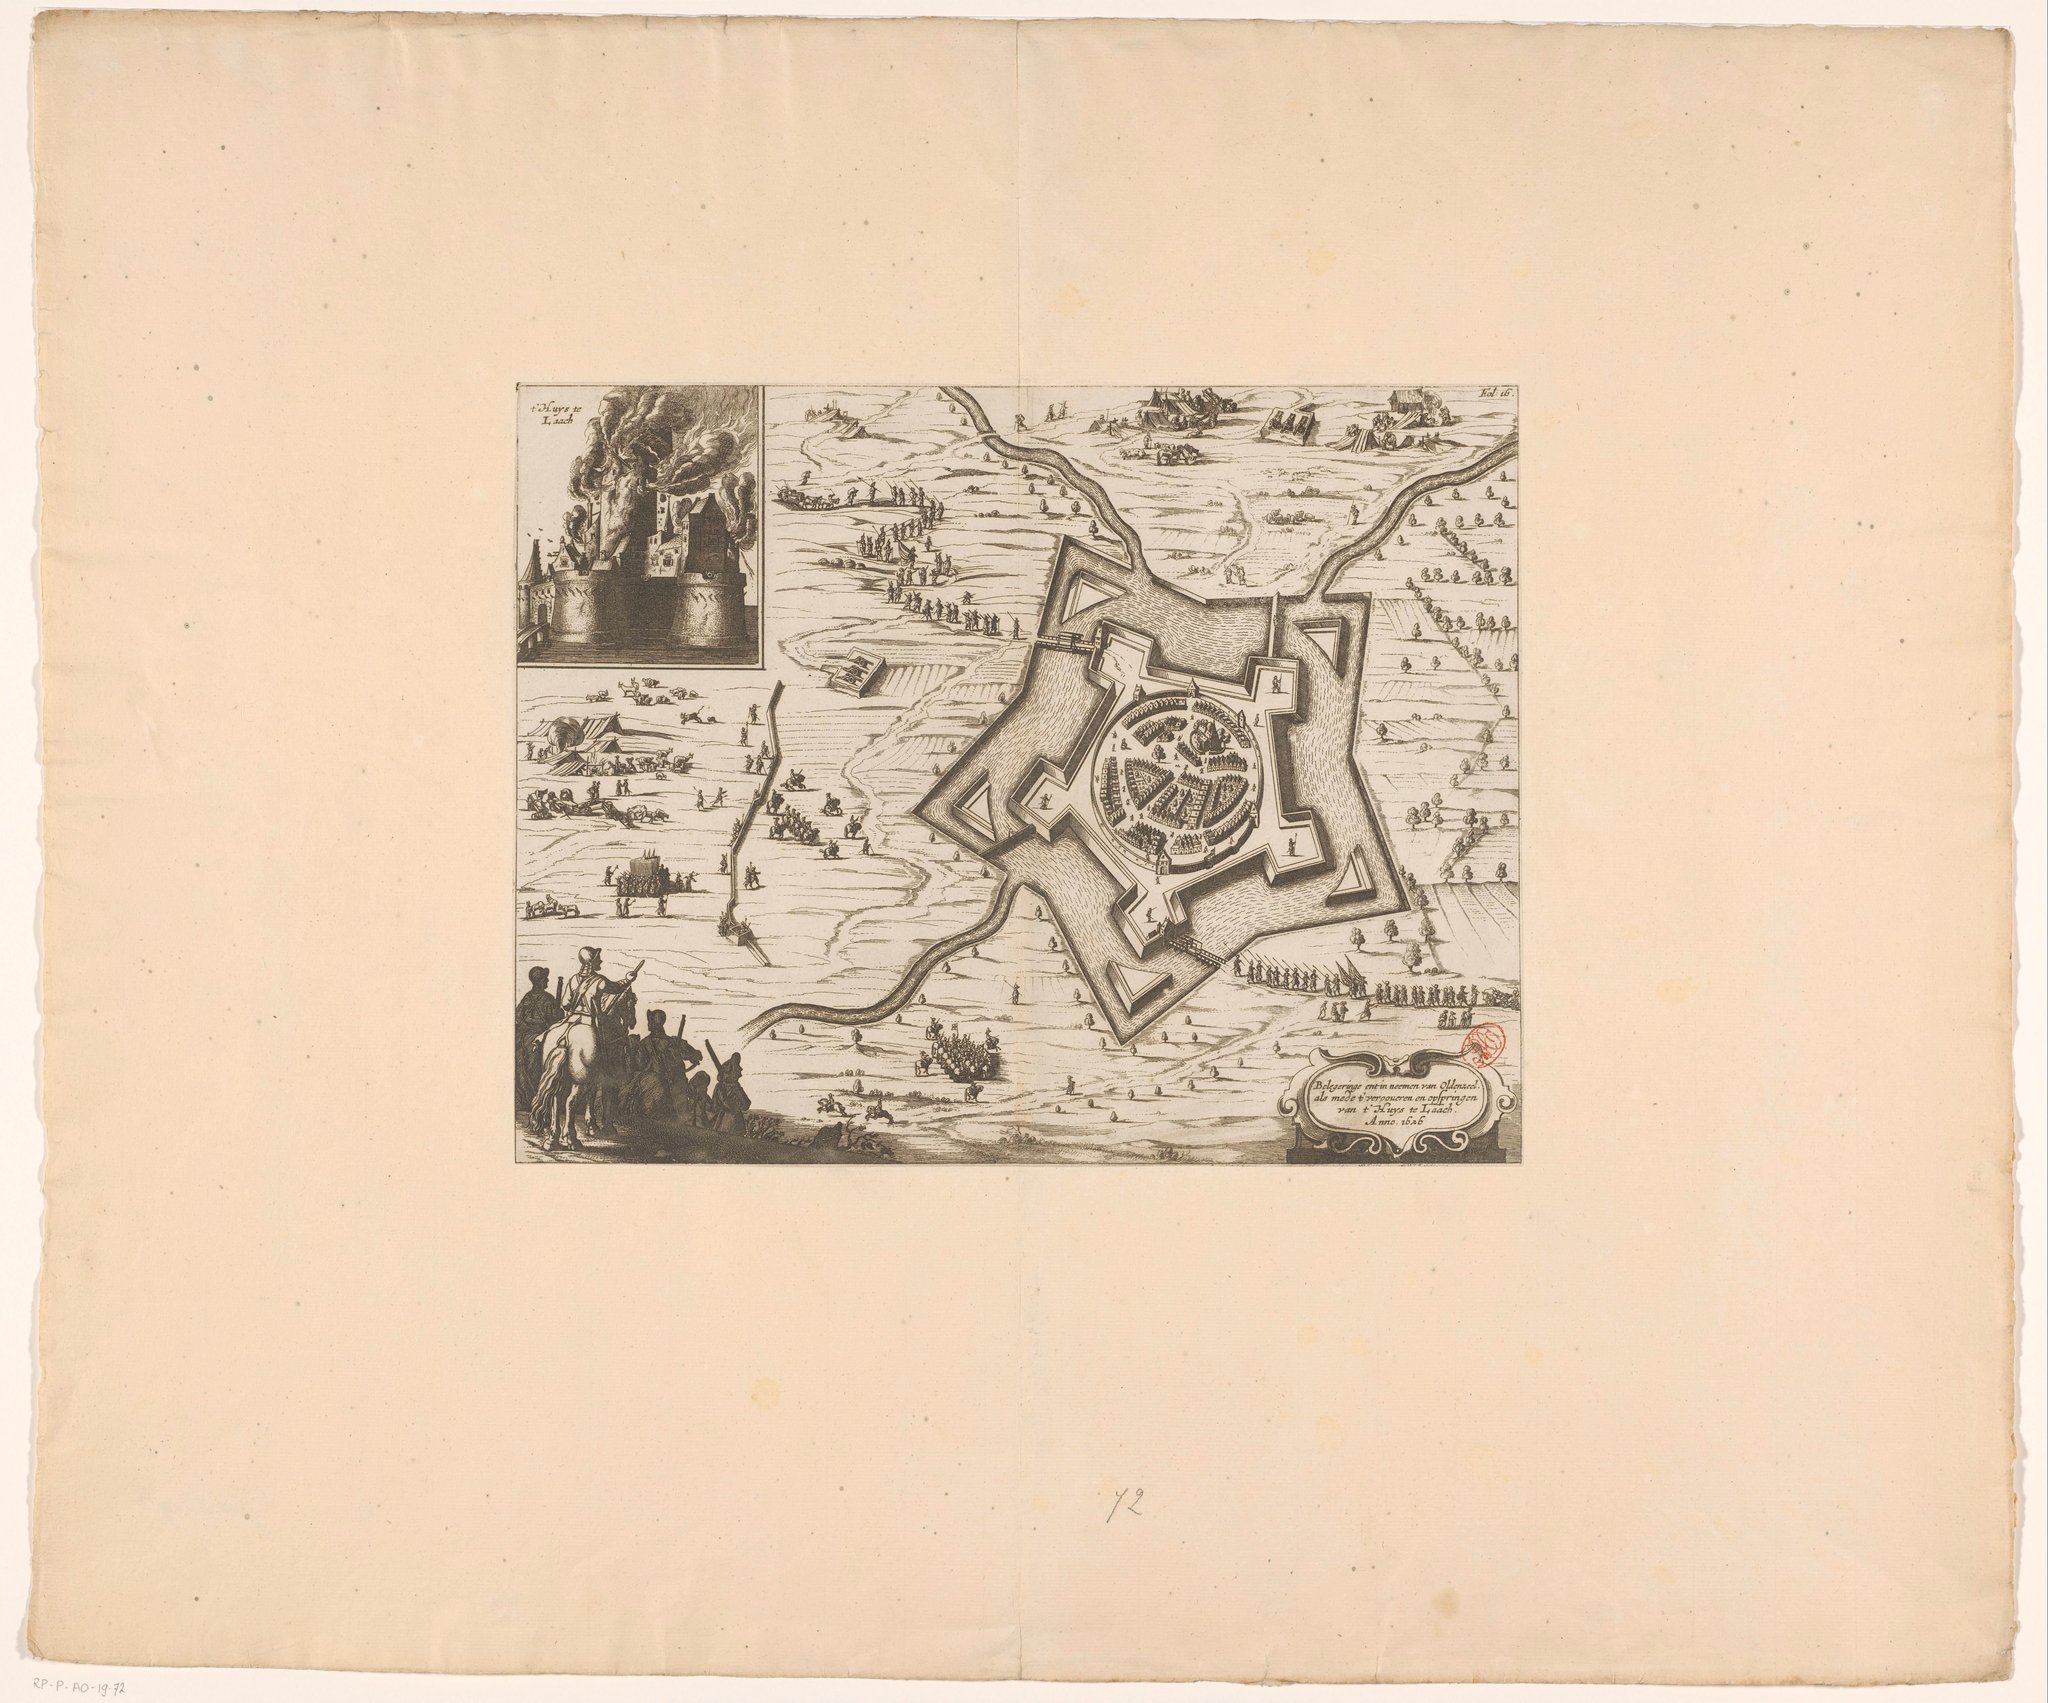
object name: print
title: Beleg en inname van Oldenzaal, 1626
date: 1651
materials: paper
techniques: etching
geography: amsterdam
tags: ernst casimir graaf van nassau-dietz, siege, position war, capture of city (after the siege)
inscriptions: collector's mark: Lugt 195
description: Het beleg en de inname van Oldenzaal door het Staatse leger onder graaf Ernst Casimir, 1 augustus 1626. Kaart van de versterkte stad en omgeving met de legerkampen van de belegeraars. Op de voorgrond enkele soldaten, rechtsonder verlaten de bezetters de stad. Linksboven een inzet met het verwoesten van het Huis ter Laak. Gemerkt rechtsboven Fol. 16.